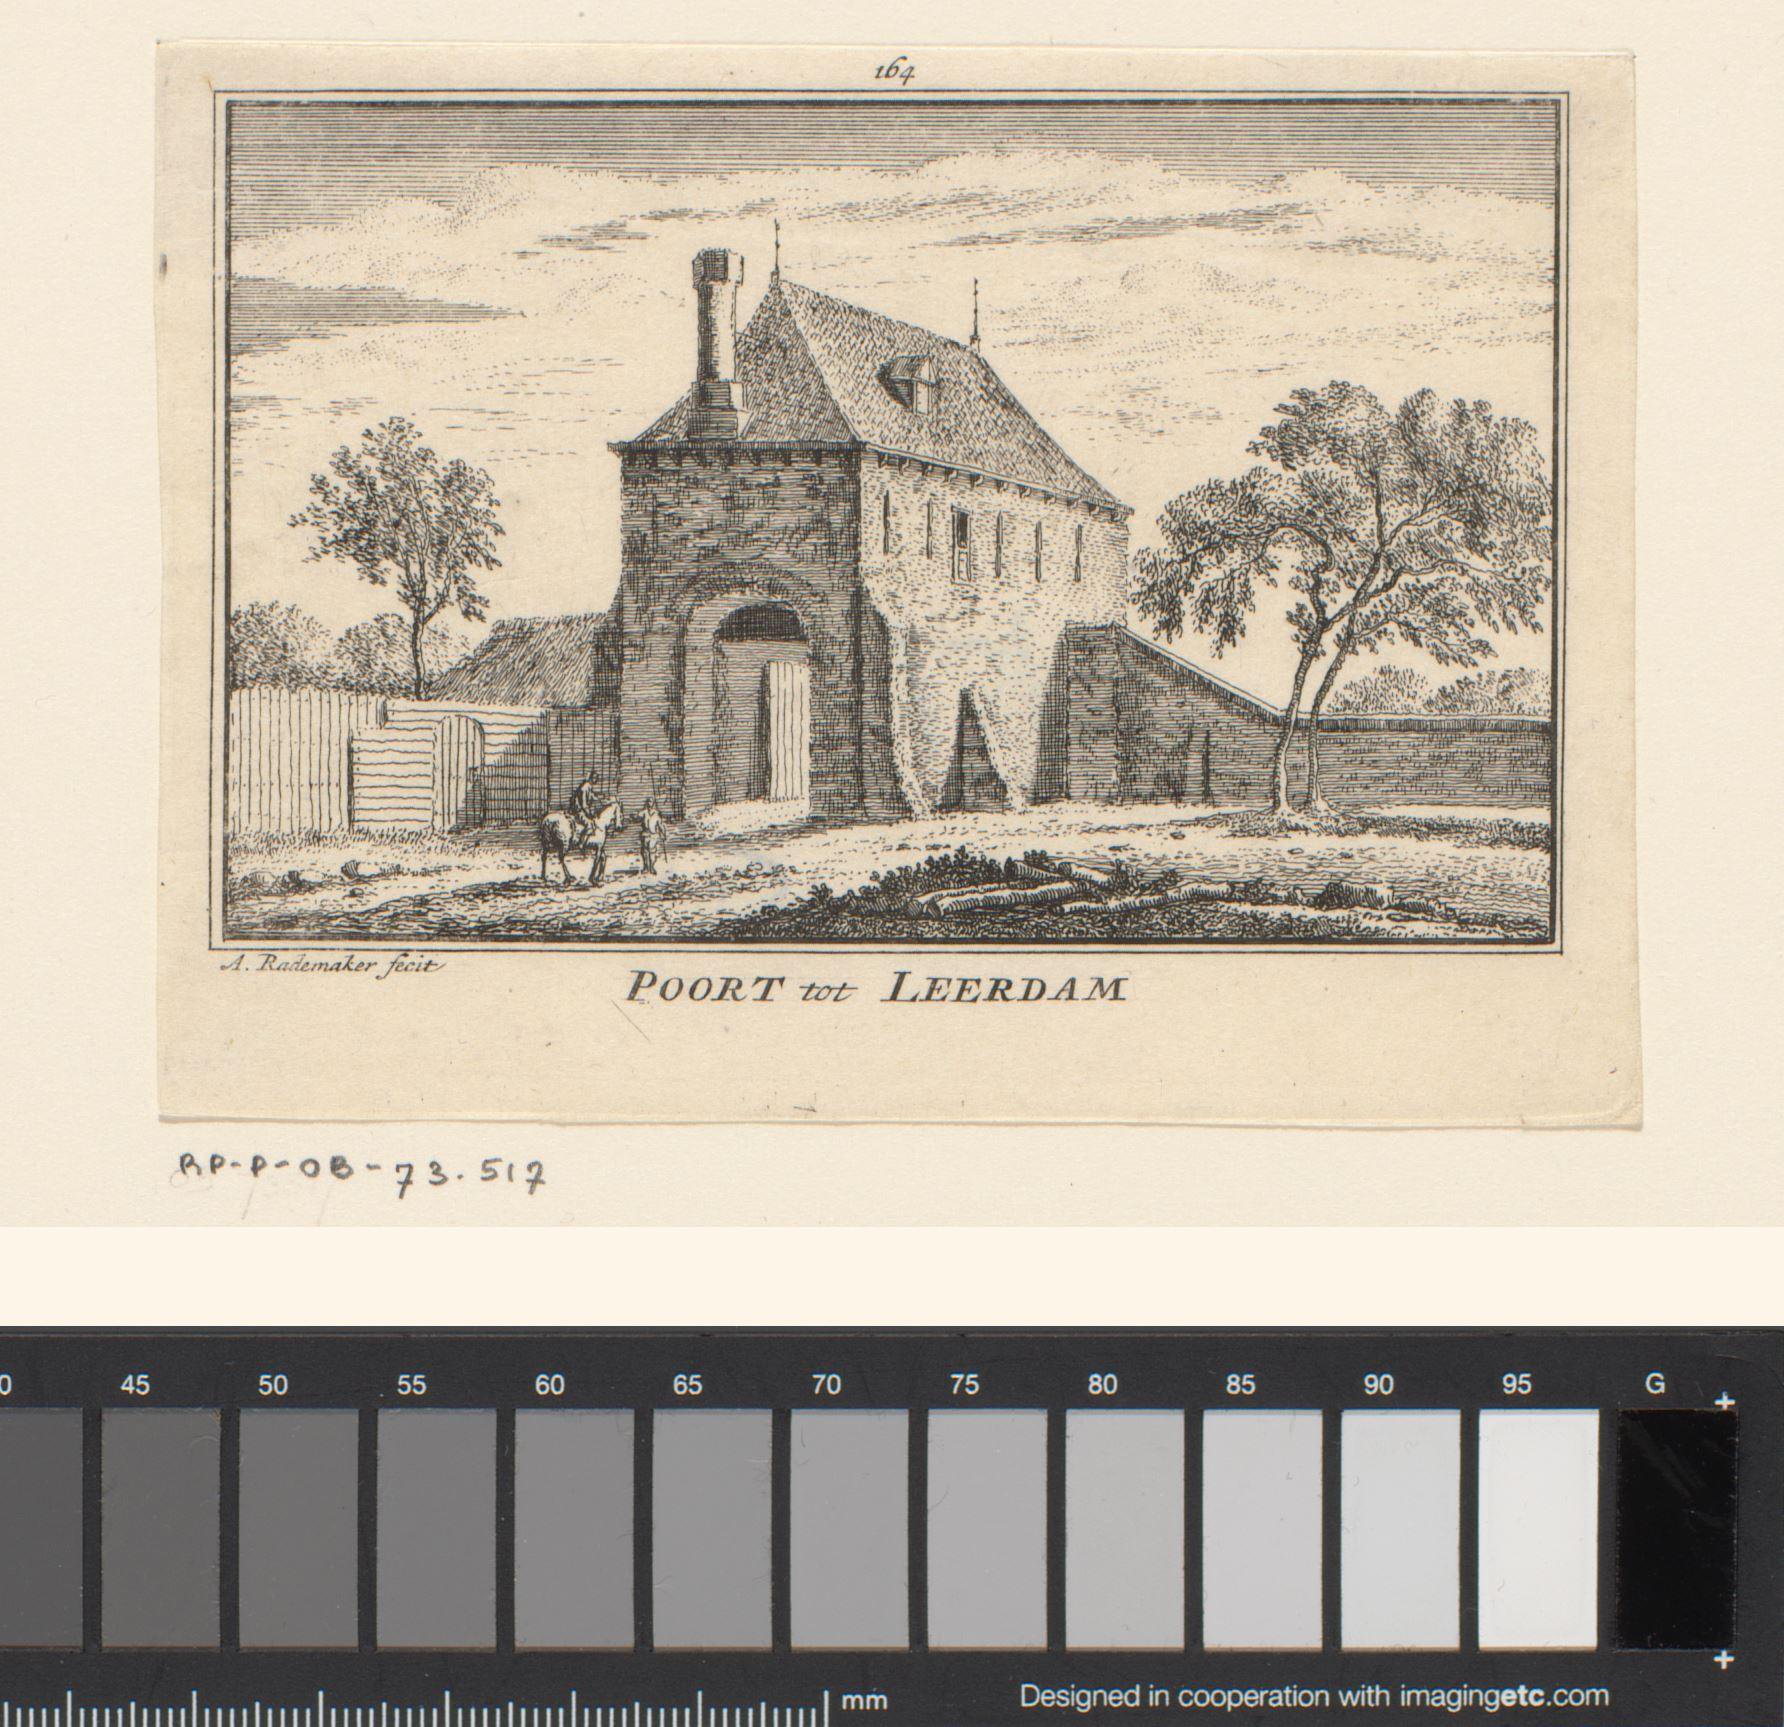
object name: print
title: Poort tot Leerdam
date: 1727-1733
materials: paper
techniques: etching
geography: amsterdam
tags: riding a horse, ass, or mule; rider, horseman, city-gate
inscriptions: collector's mark: Lugt 2228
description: Illustratie uit: Abraham Rademaker, Matthaeus Brouërius van Niedek, Isaac Le Long, Kabinet van Nederlandsche en Kleefsche outheden en (...) voorname stads- en landgebouwen, Willem Barents en Antoni Schoonenburg: Amsterdam, 1727-1733, ill. nr. 164.